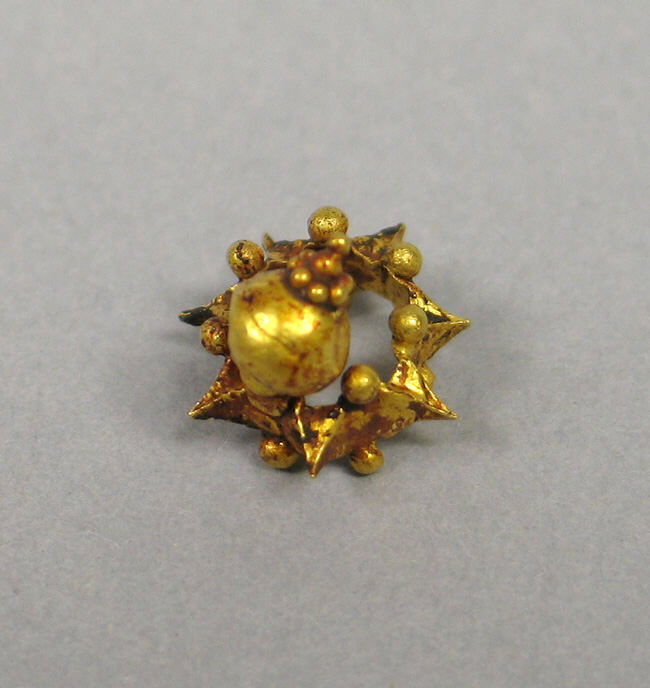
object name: ear clip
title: Pair of Ear Clips with Keben Fruit Motif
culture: indonesian, javanese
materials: gold